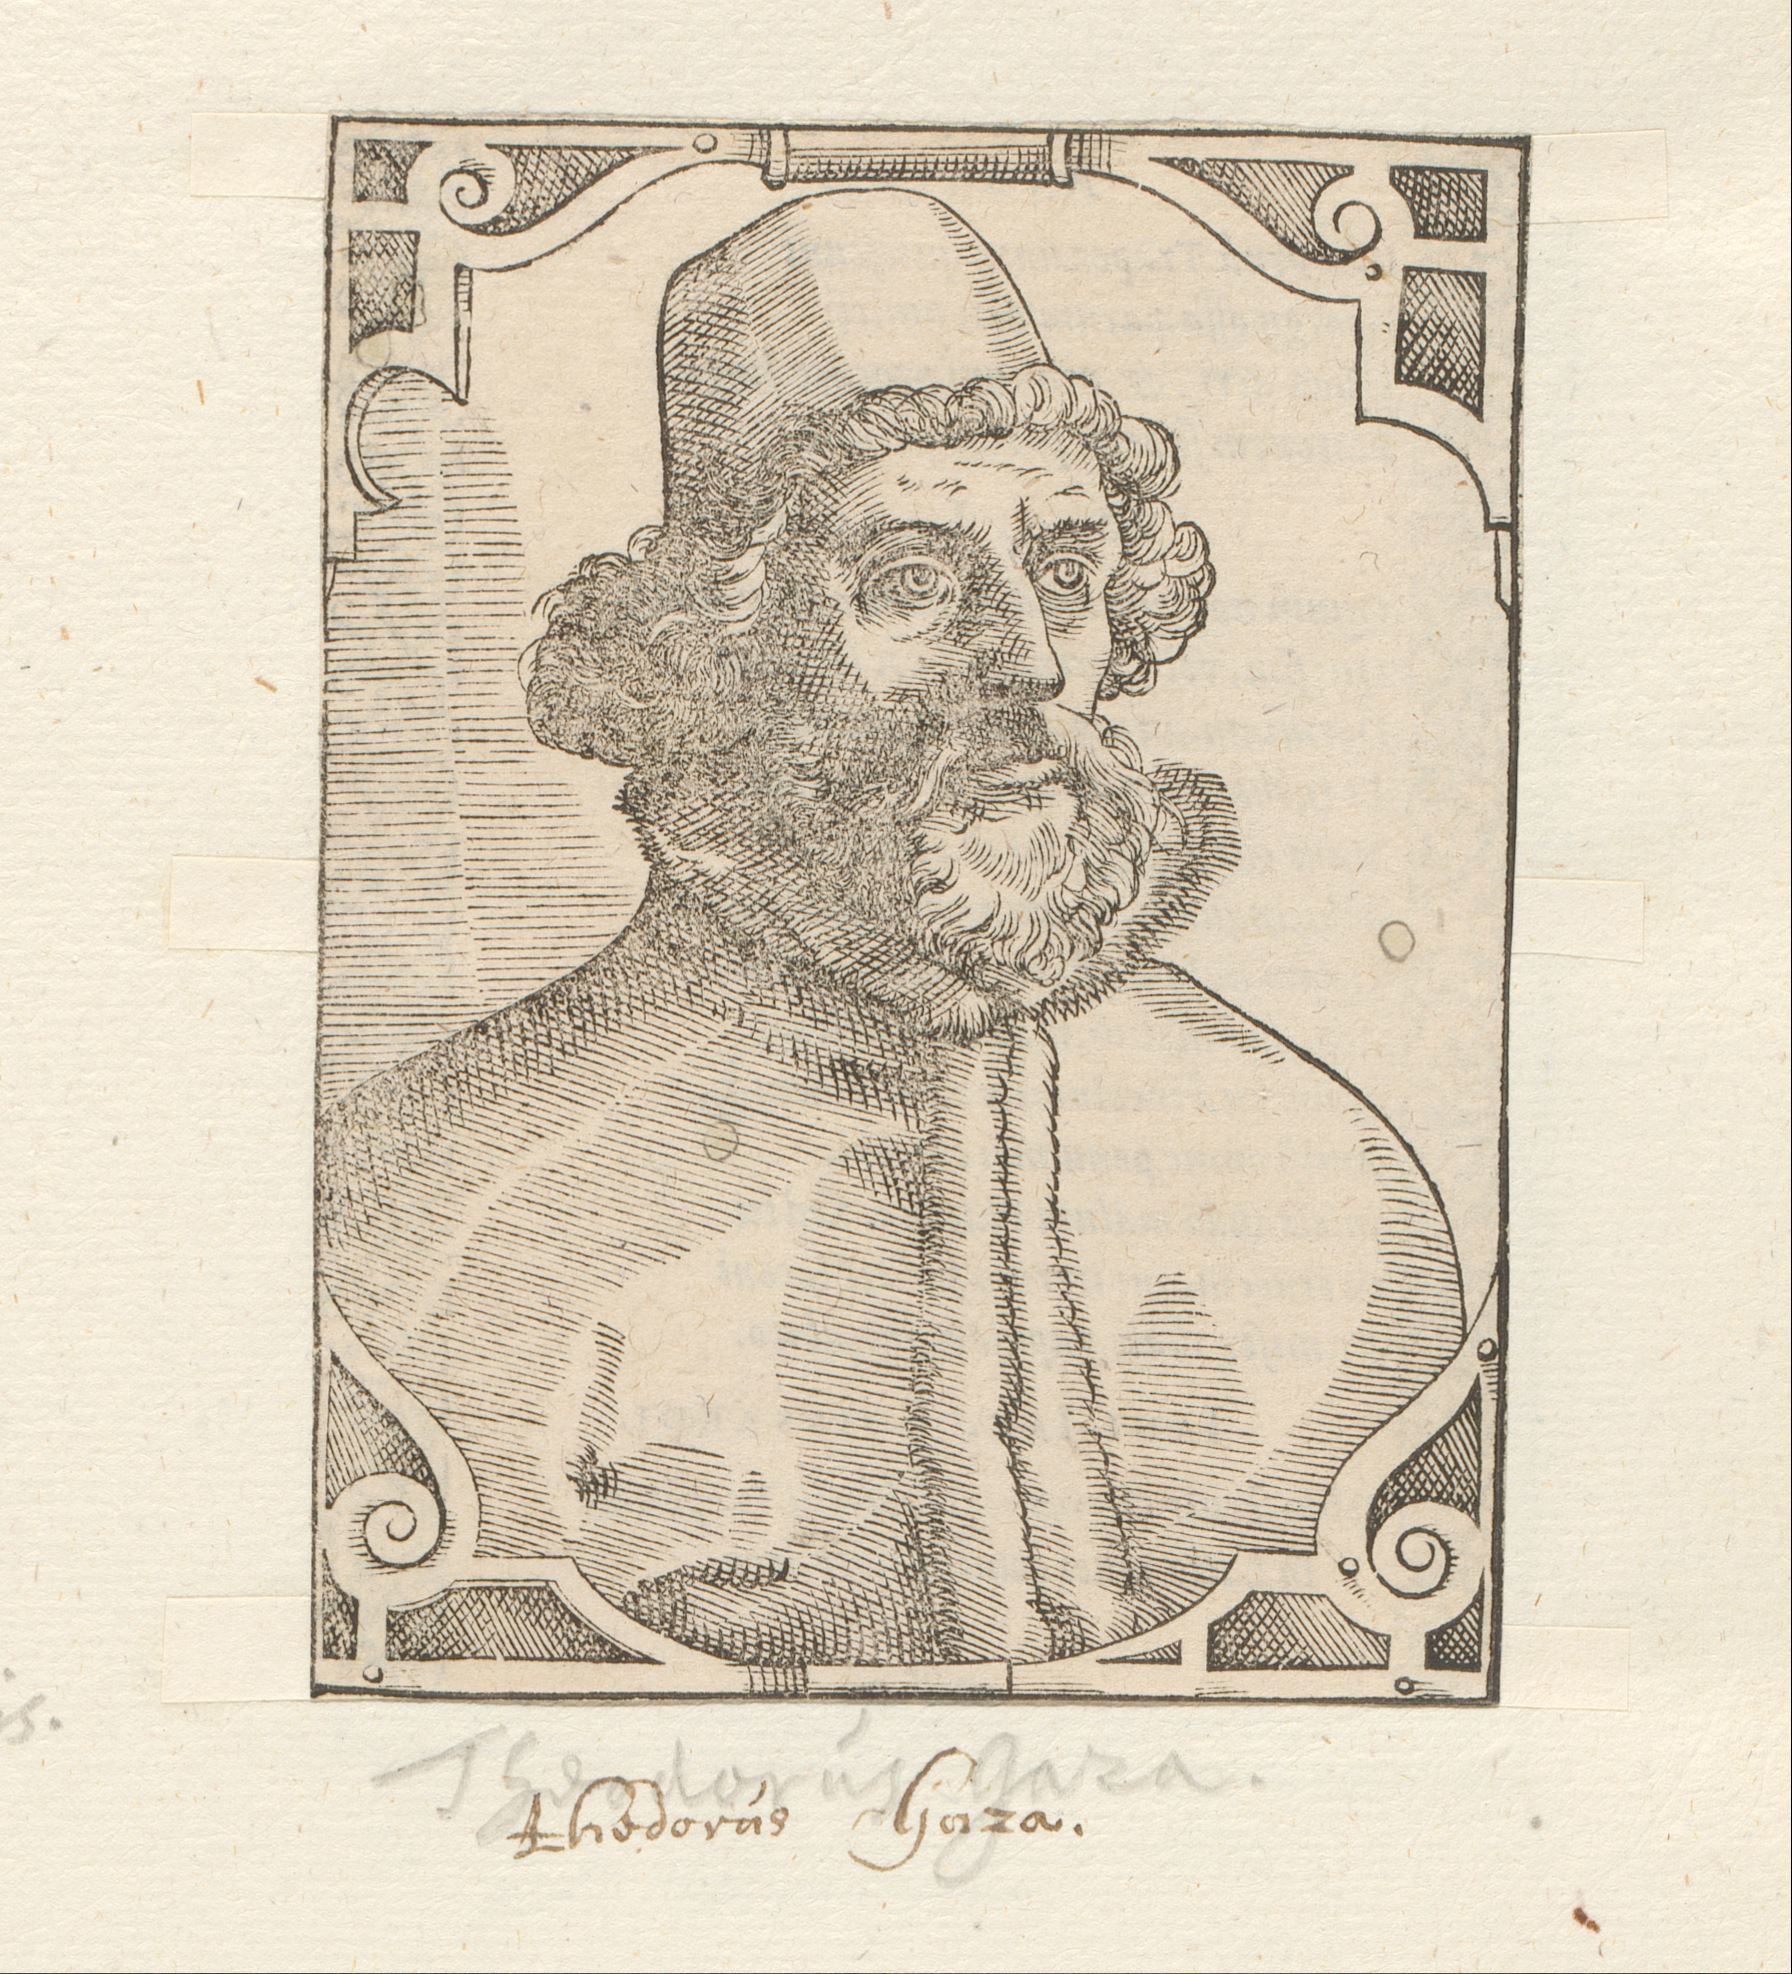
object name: album leaf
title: Portret van Theodorus Gaza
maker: Anonymous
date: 1549-1577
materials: paper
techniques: letterpress printing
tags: calabria, historical persons, scholar, philosopher (+ portrait of scholar, scientist)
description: Prent gebruikt in: Giovio, Paolo. Elogia Virorum literis illustrium (...). Bazel: Peter Perna, 1577.